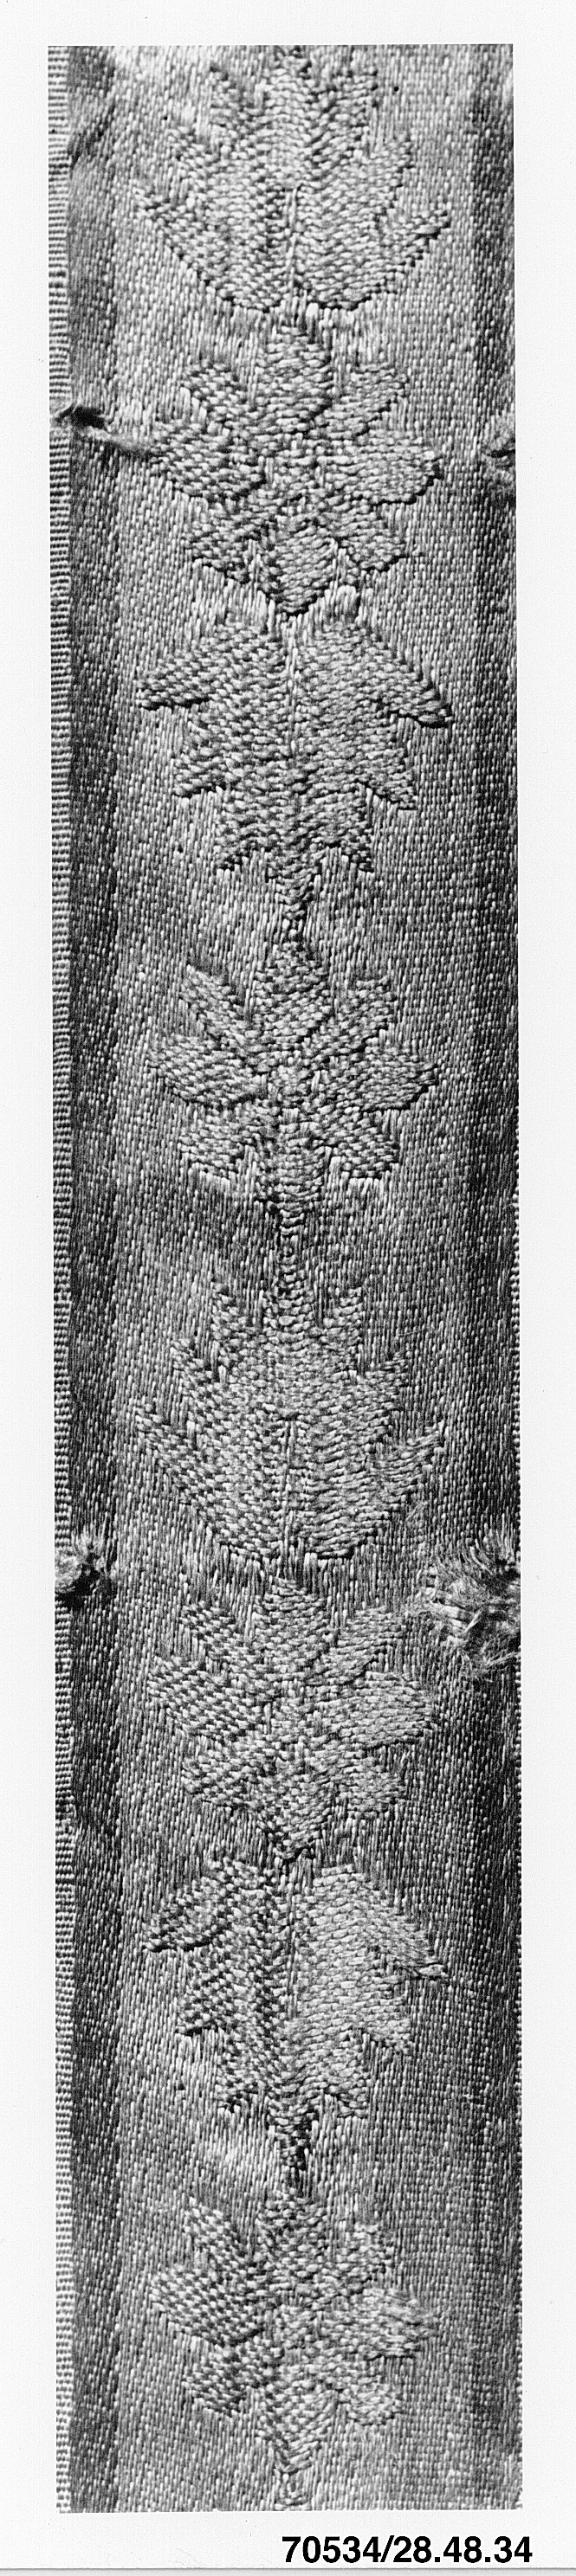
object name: border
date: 1801-1900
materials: silk